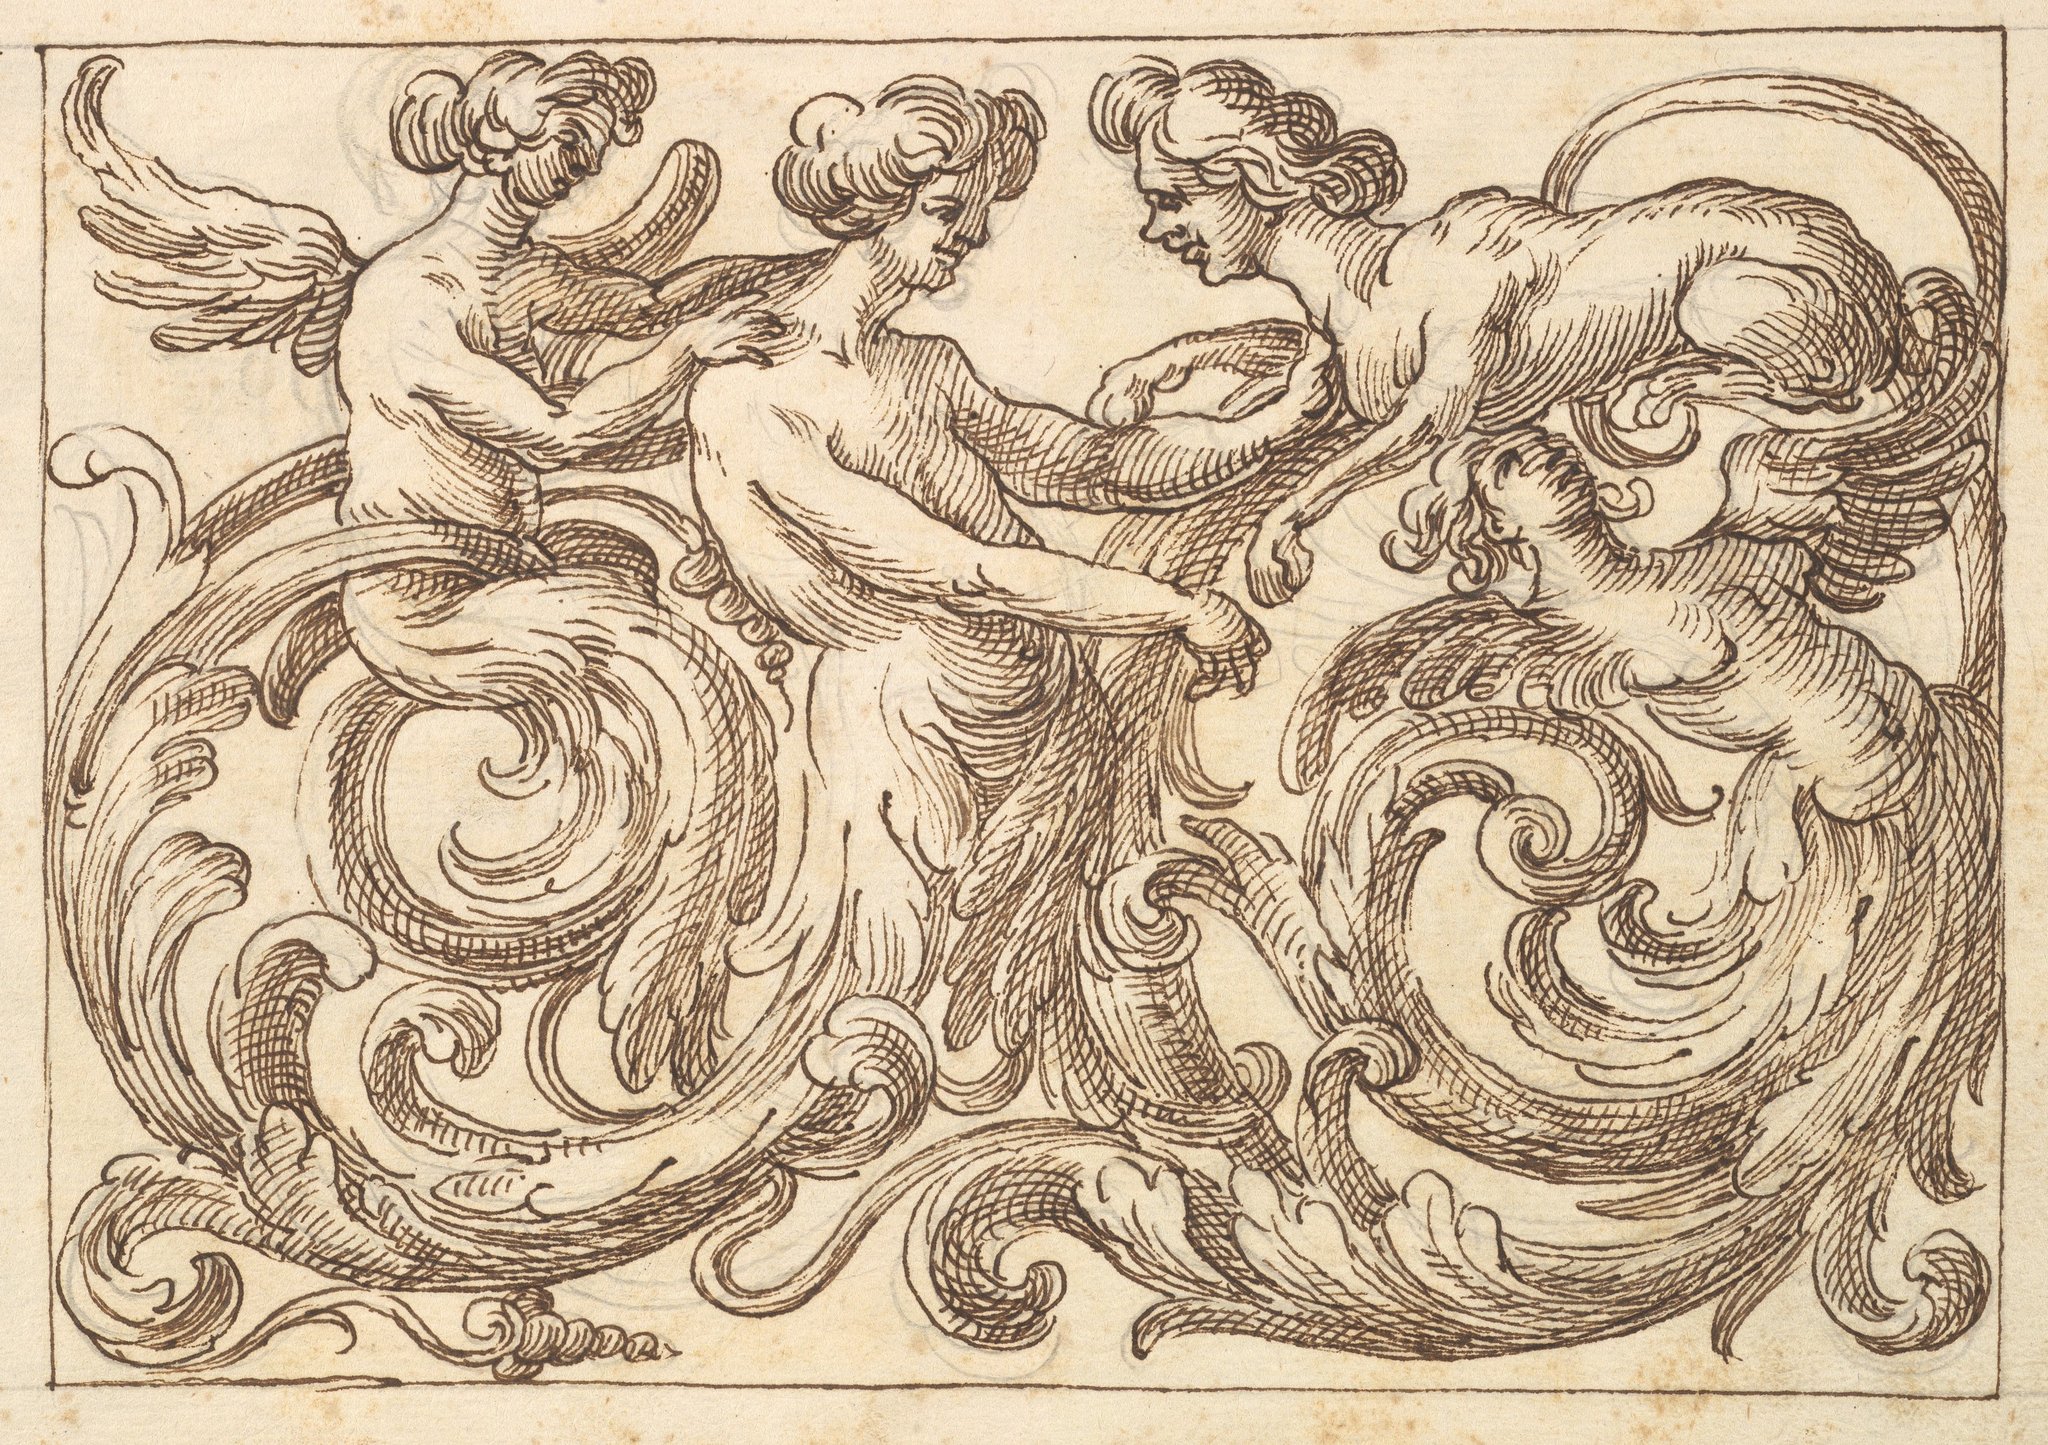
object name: collection ornament architecture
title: Horizontal Panel Design with a Three Androgynous Figures and a Sphinx Combined with Acanthus Rinceaux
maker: anonymous, italian, venetian, 17th century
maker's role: artist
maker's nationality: italian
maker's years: 1600-1700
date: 1601-1700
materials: ink, drawing material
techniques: pen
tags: sphinx